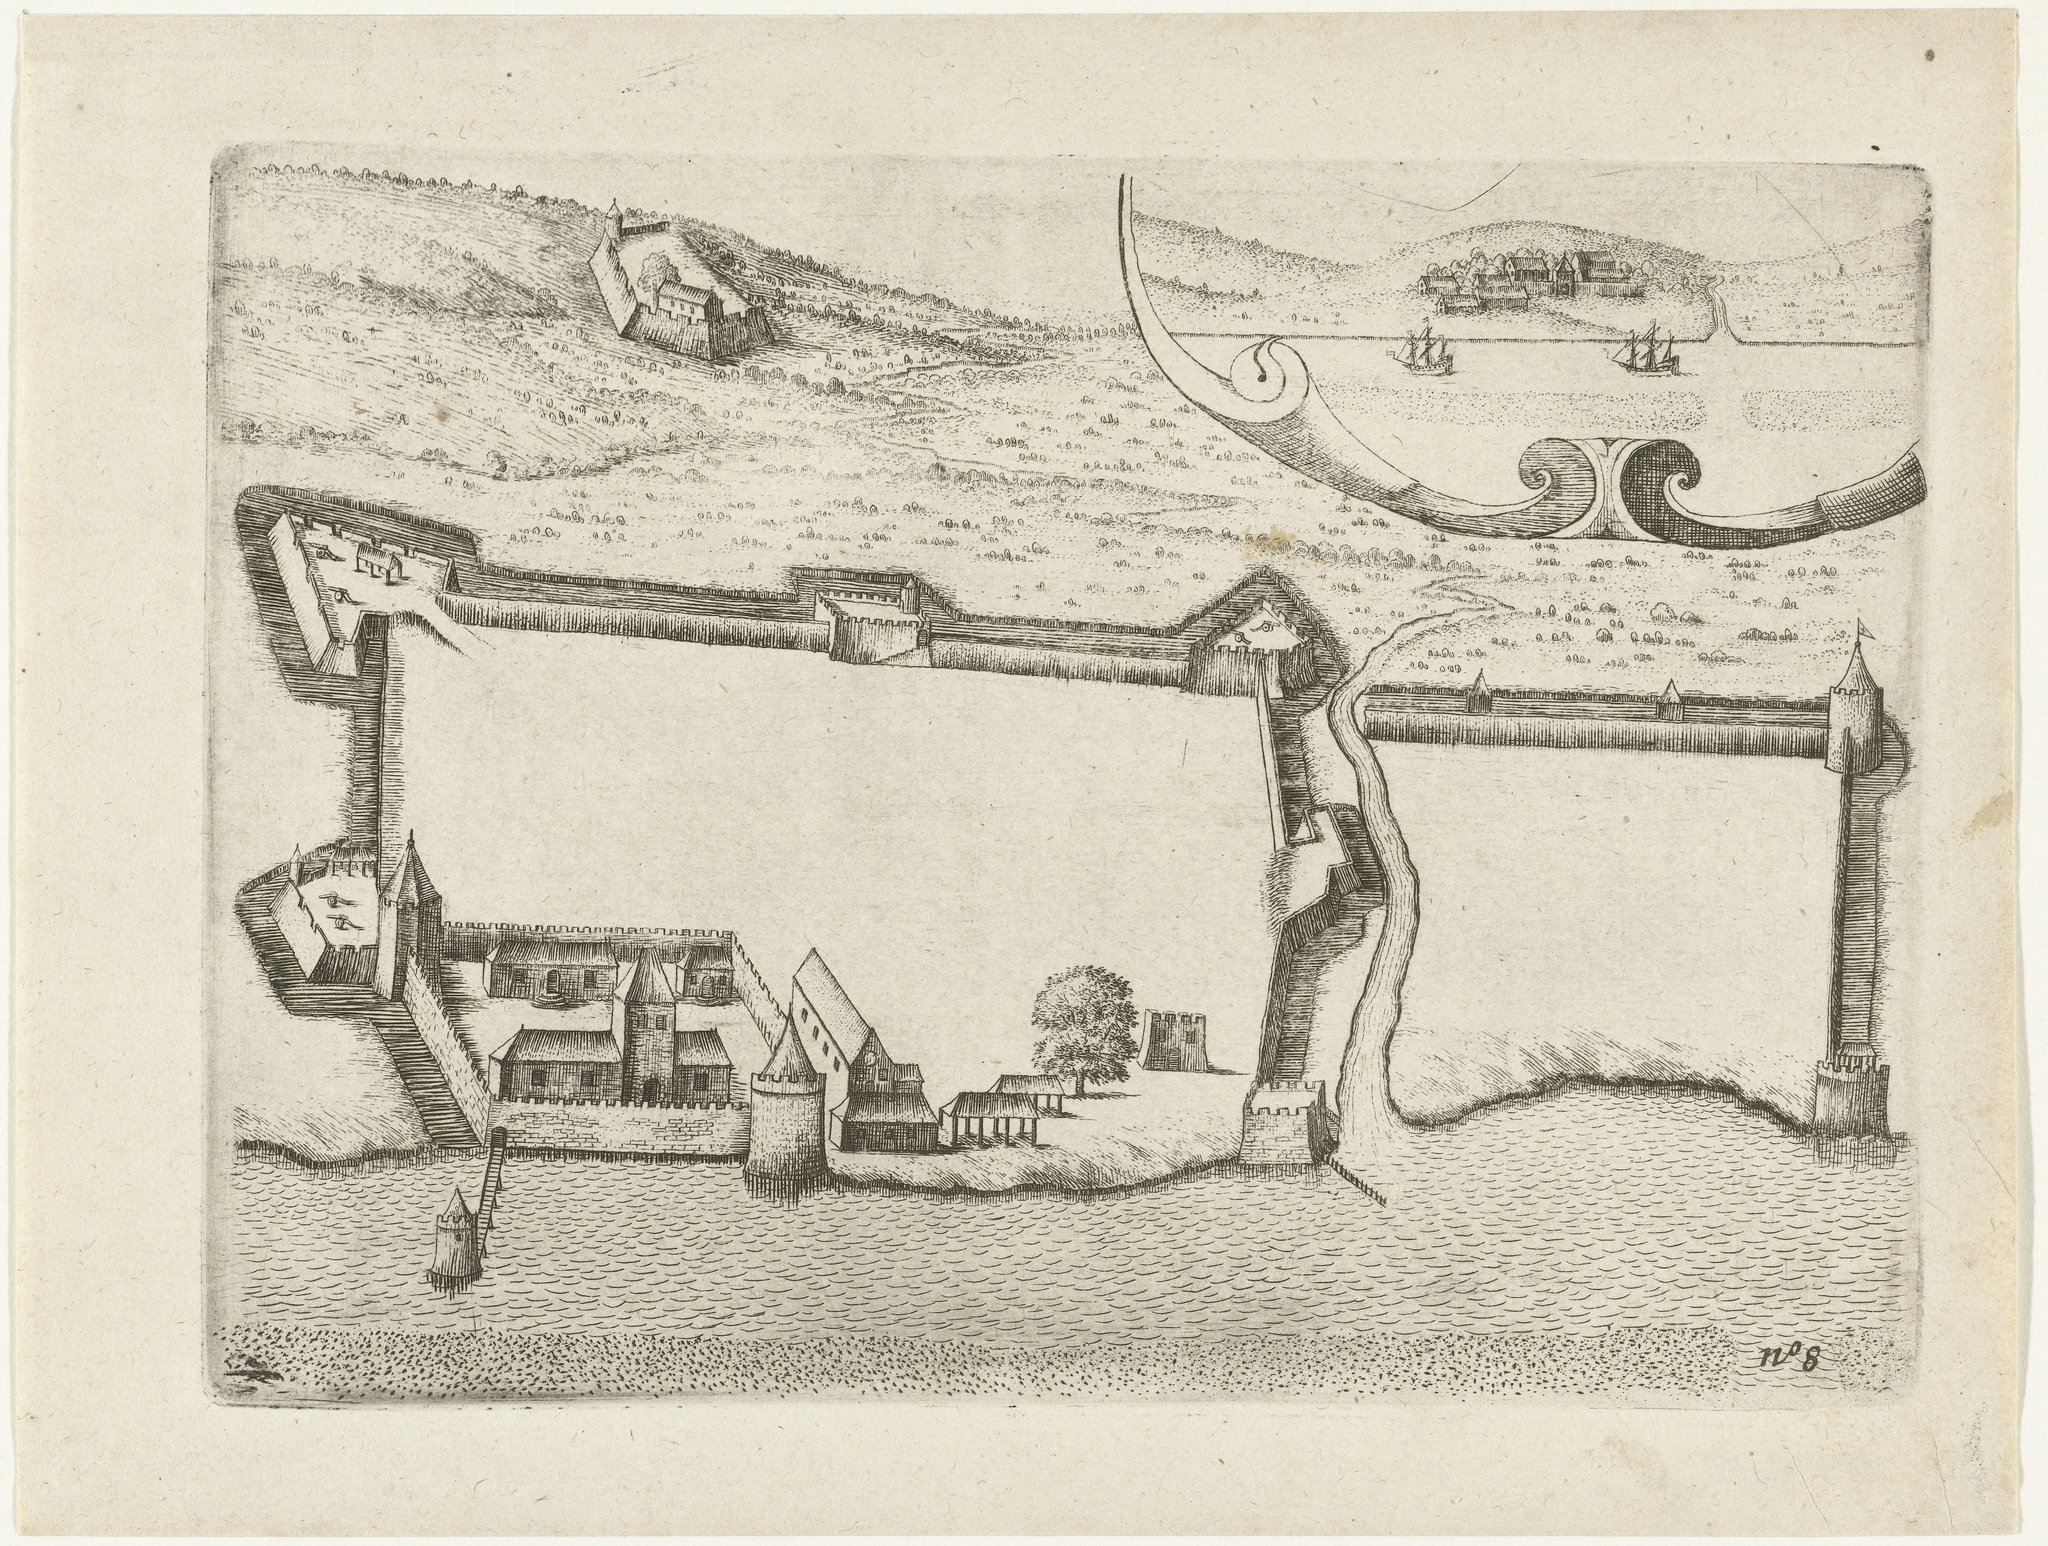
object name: print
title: De Stadt van Gamalama in't Eylant Ternate, by den Spaensche beseten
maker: Anonymous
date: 1644-1646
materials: paper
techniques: etching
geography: northern netherlands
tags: rotterdam, mayor, landscapes in tropical and sub-tropical regions, exploration, expedition, voyage of discovery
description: Gebruikt als illustratie: Historisch Verhael Vande treffelijcke Reyse, gedaen naer de Oost-Indien ende China, met elf Schepen. Door den Manhaften Admirael Cornelis Matelief de Jonge. Inden Jaren 1605. 1606. 1607. ende 1608. Deze tekst opgenomen in : I. Commelin, Begin ende voortgangh, van de Vereenighde Nederlantsche Geoctroyeerde Oost-Indische Compagnie, J. Janssonius, Amsterdam 1646. Genummerd: No. 8.